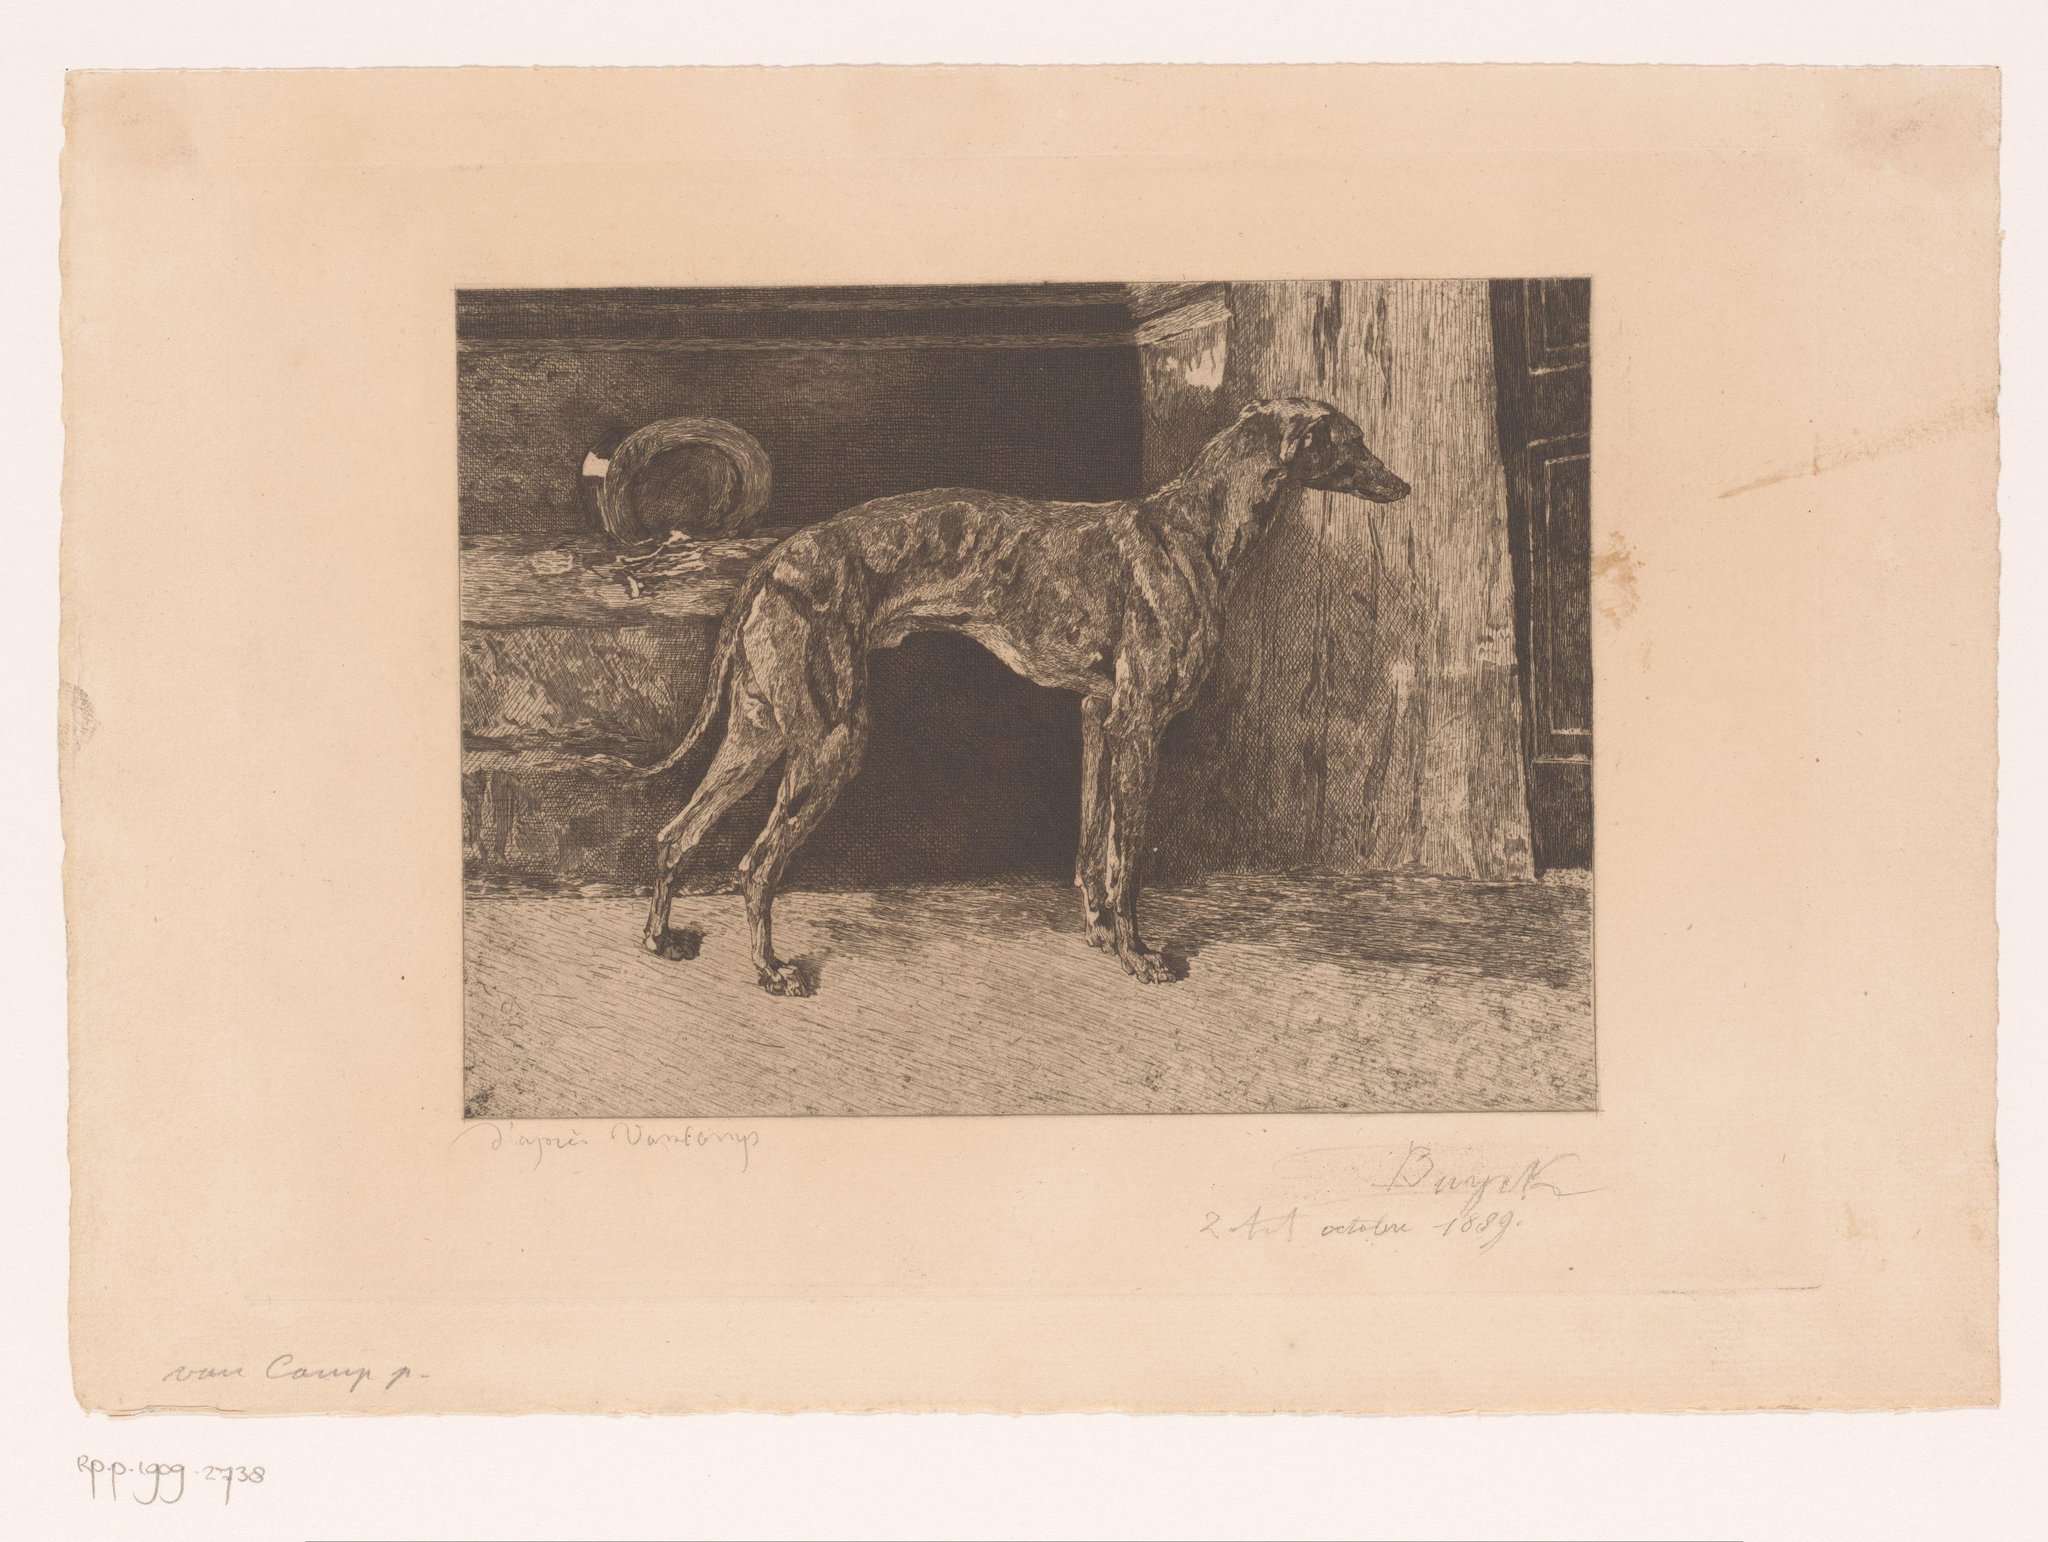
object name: print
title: Windhond voor een gesloten deur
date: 1810-1889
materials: paper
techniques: etching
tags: dog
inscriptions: annotation: ‘2 etat’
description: Sterfdatum prentmaker onbekend. Derhalve is voor bepaling van de rechten van dit object de verwervingsdatum aangehouden.